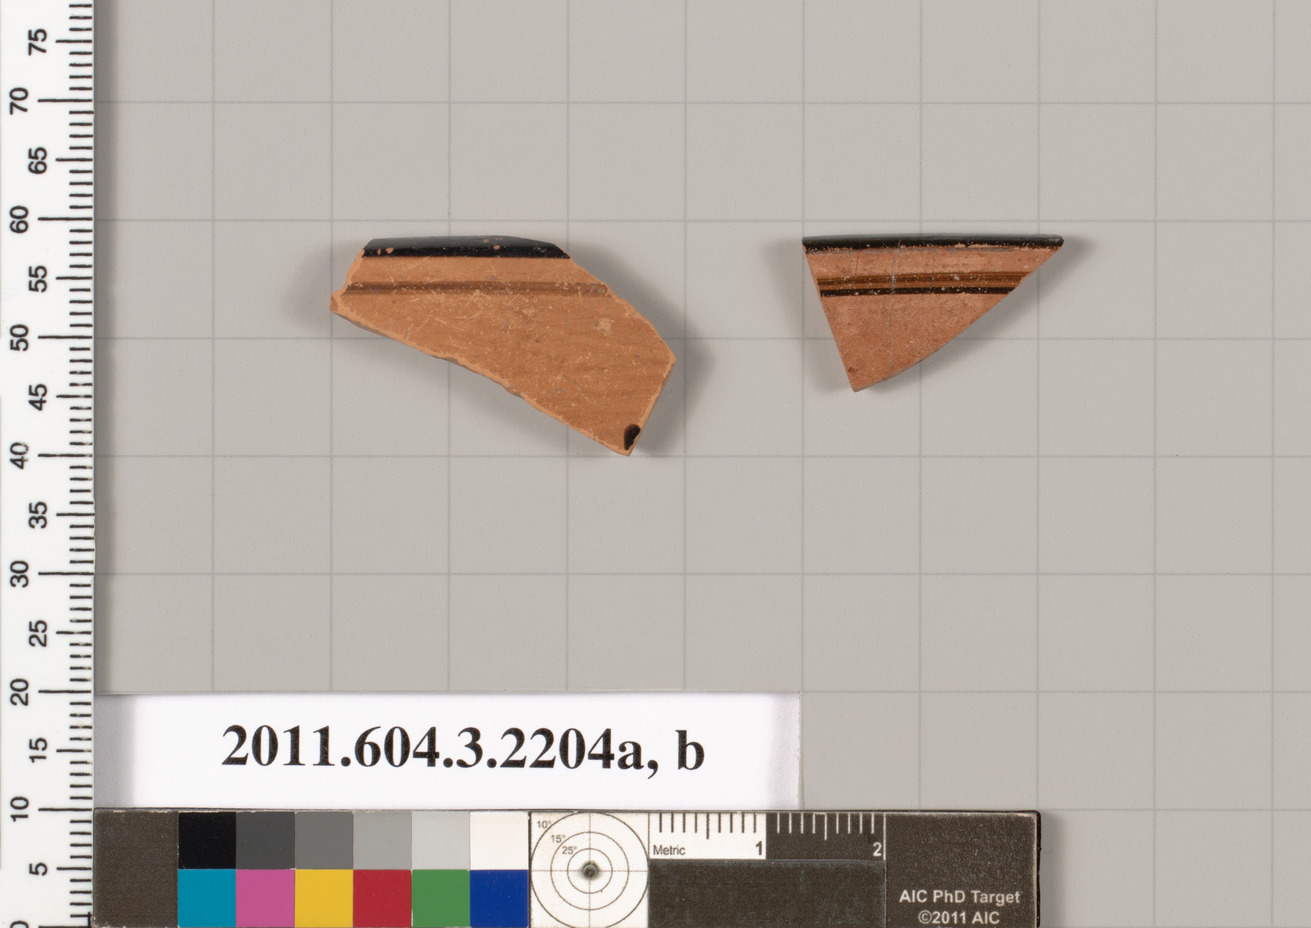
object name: kylix fragment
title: Terracotta rim fragments of kylikes (drinking cups)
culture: greek, attic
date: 600-401 BCE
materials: terracotta